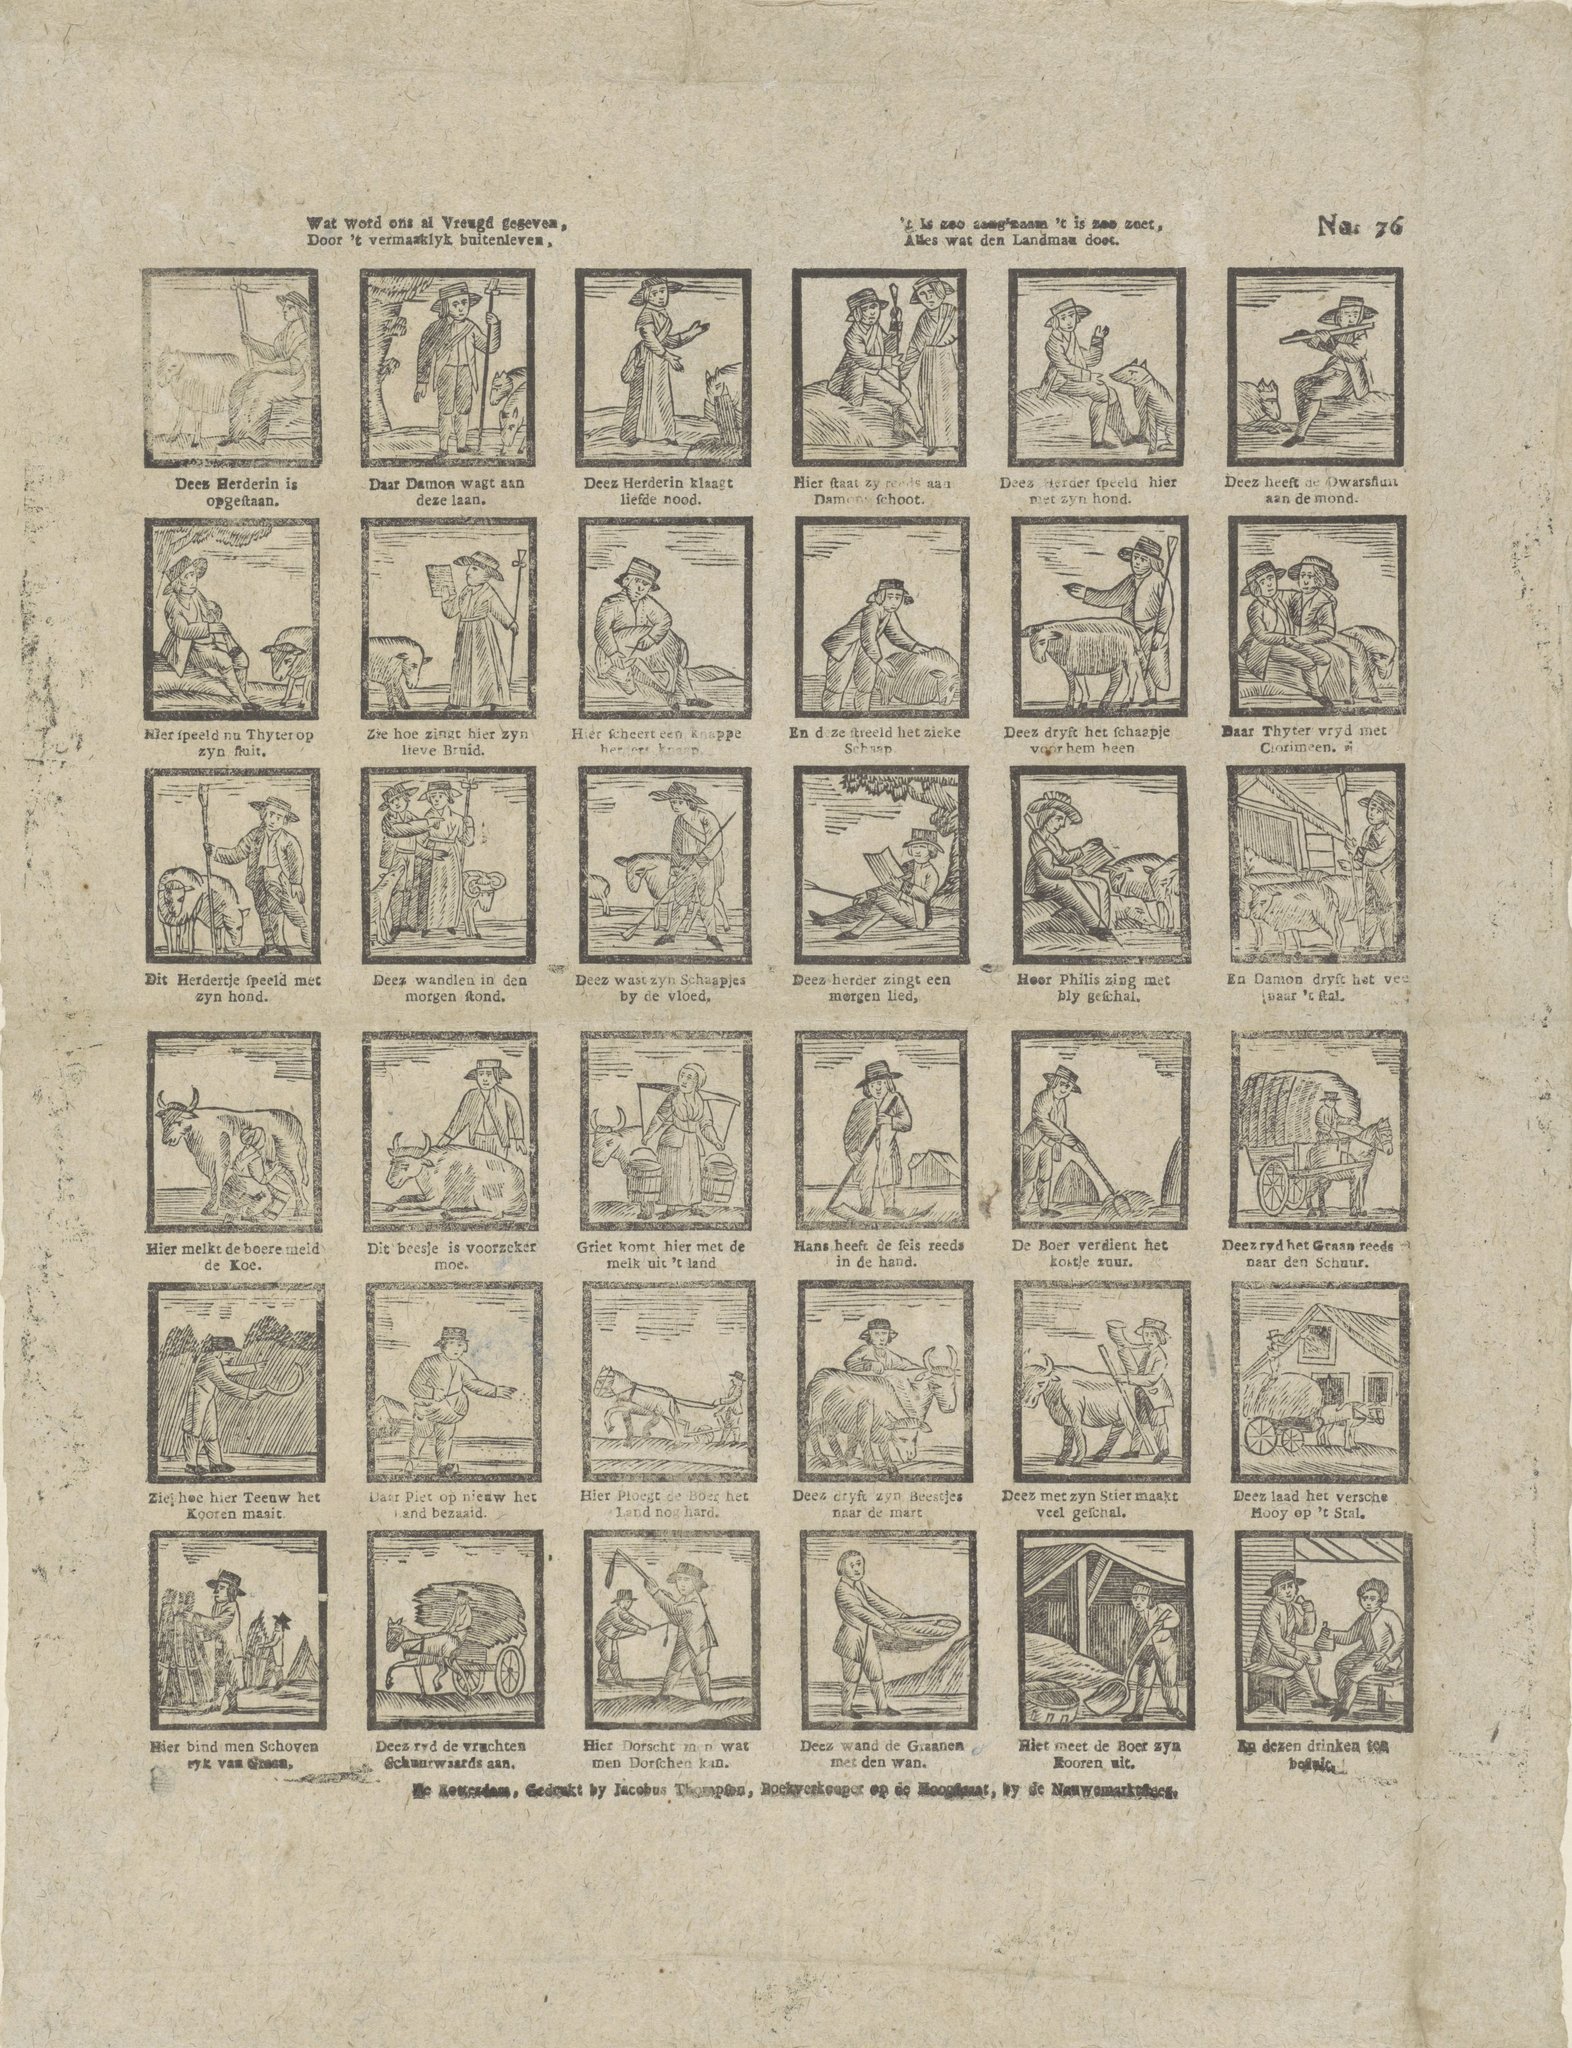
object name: popular print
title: Wat word ons al vreugd gegeven, / Door 't vermaaklyk buitenleven, / 't is zoo aang'naam 't is zoo zoet, / Alles wat den landman doet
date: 1791-1812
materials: paper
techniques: letterpress printing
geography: netherlands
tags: farmers, agriculture, herd, flock, milking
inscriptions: collector's mark: Lugt 2760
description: Blad met 36 voorstellingen van landelijke taferelen, waaronder taferelen met herders en herderinnen, koeien melken en het land bewerken. Onder elke voorstelling een onderschrift. Genummerd rechtsboven: No. 76.